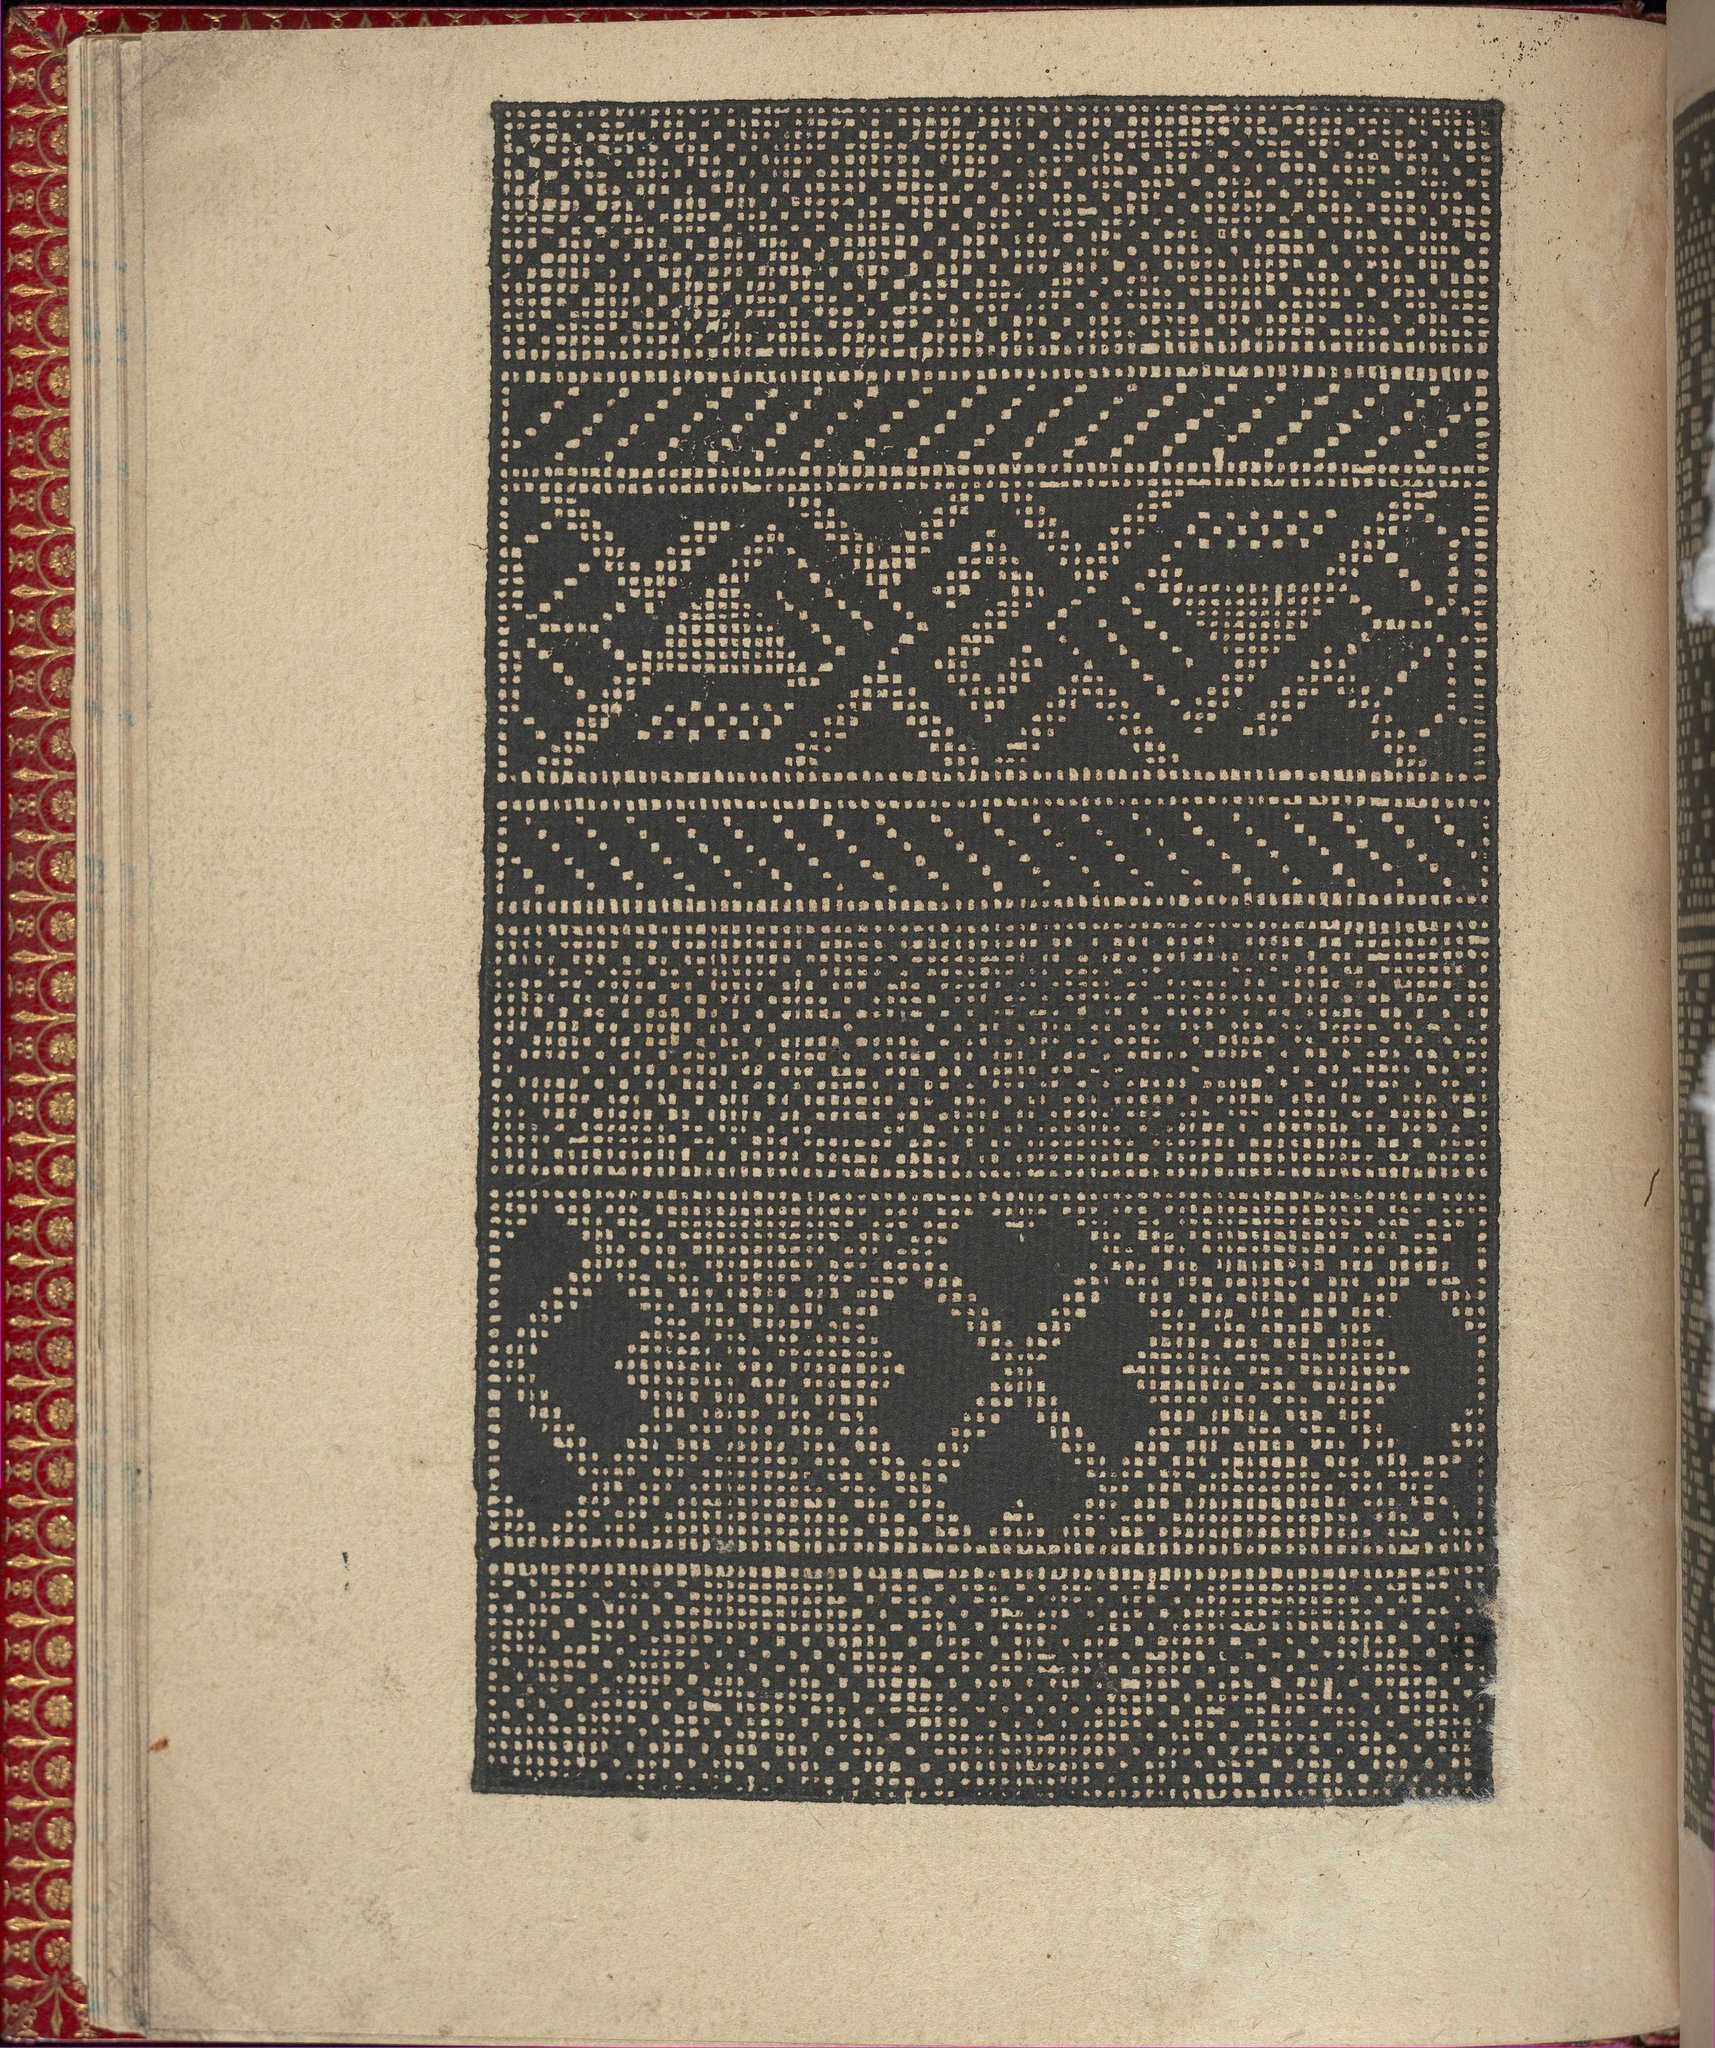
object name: book print ornament architecture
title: Ce est ung tractat de la noble art de leguille ascavoir ouvraiges de spaigne... page 6 (verso)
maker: willem vosterman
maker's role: printer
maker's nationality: netherlandish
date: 1527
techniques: woodcut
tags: ornament